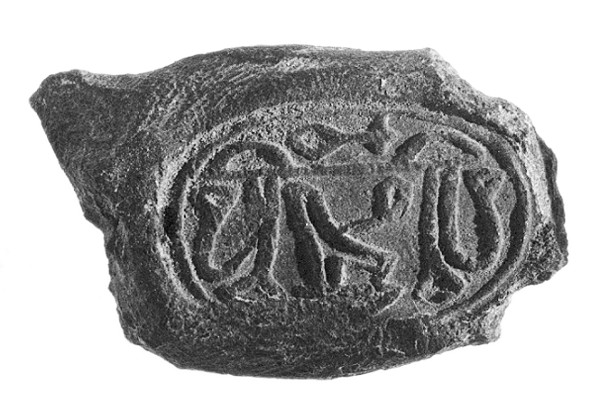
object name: sealing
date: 1981-1640 BCE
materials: clay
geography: egypt